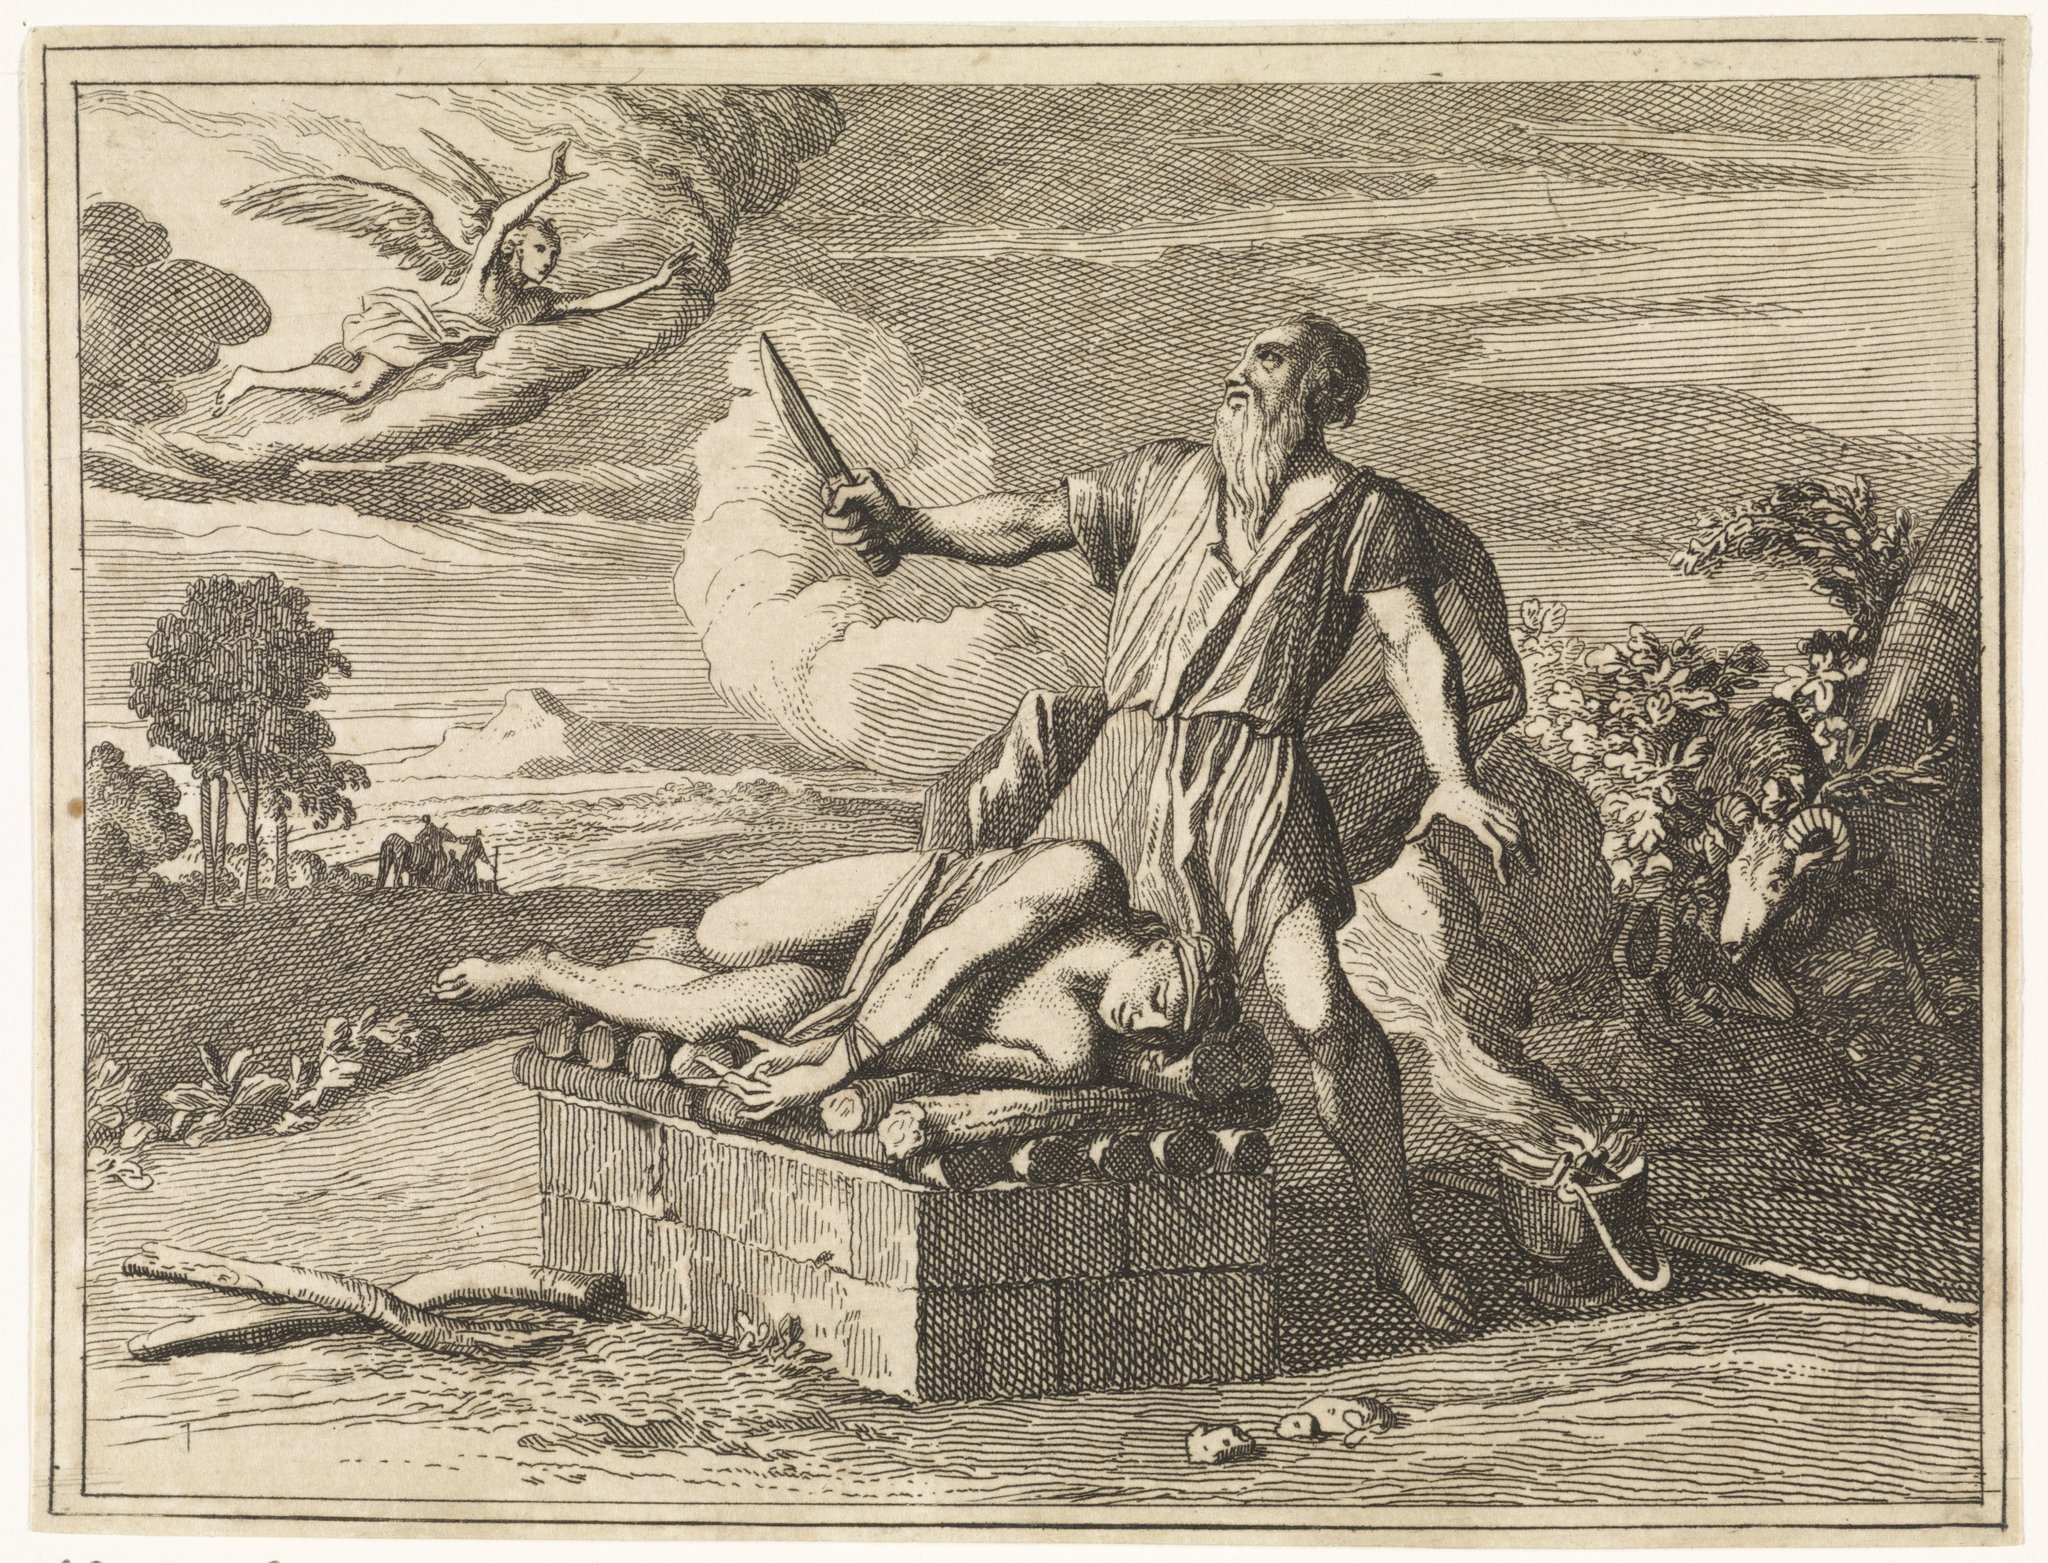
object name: print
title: Offer van Isaac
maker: caspar luyken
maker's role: draughtsman, print maker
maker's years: 1672-1708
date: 1712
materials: paper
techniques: etching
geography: amsterdam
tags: the sacrifice of isaac (genesis 22)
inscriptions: collector's mark: Lugt 2228, number: ‘25’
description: Illustratie uit: Luyken, Jan. De schriftuurlyke geschiedenissen en gelykenissen van het Oude en Nieuwe Verbond, 2 delen. Amsterdam: Wed. Pieter Arentsz II en Cornelis van der Sys, 1712, dl. I.